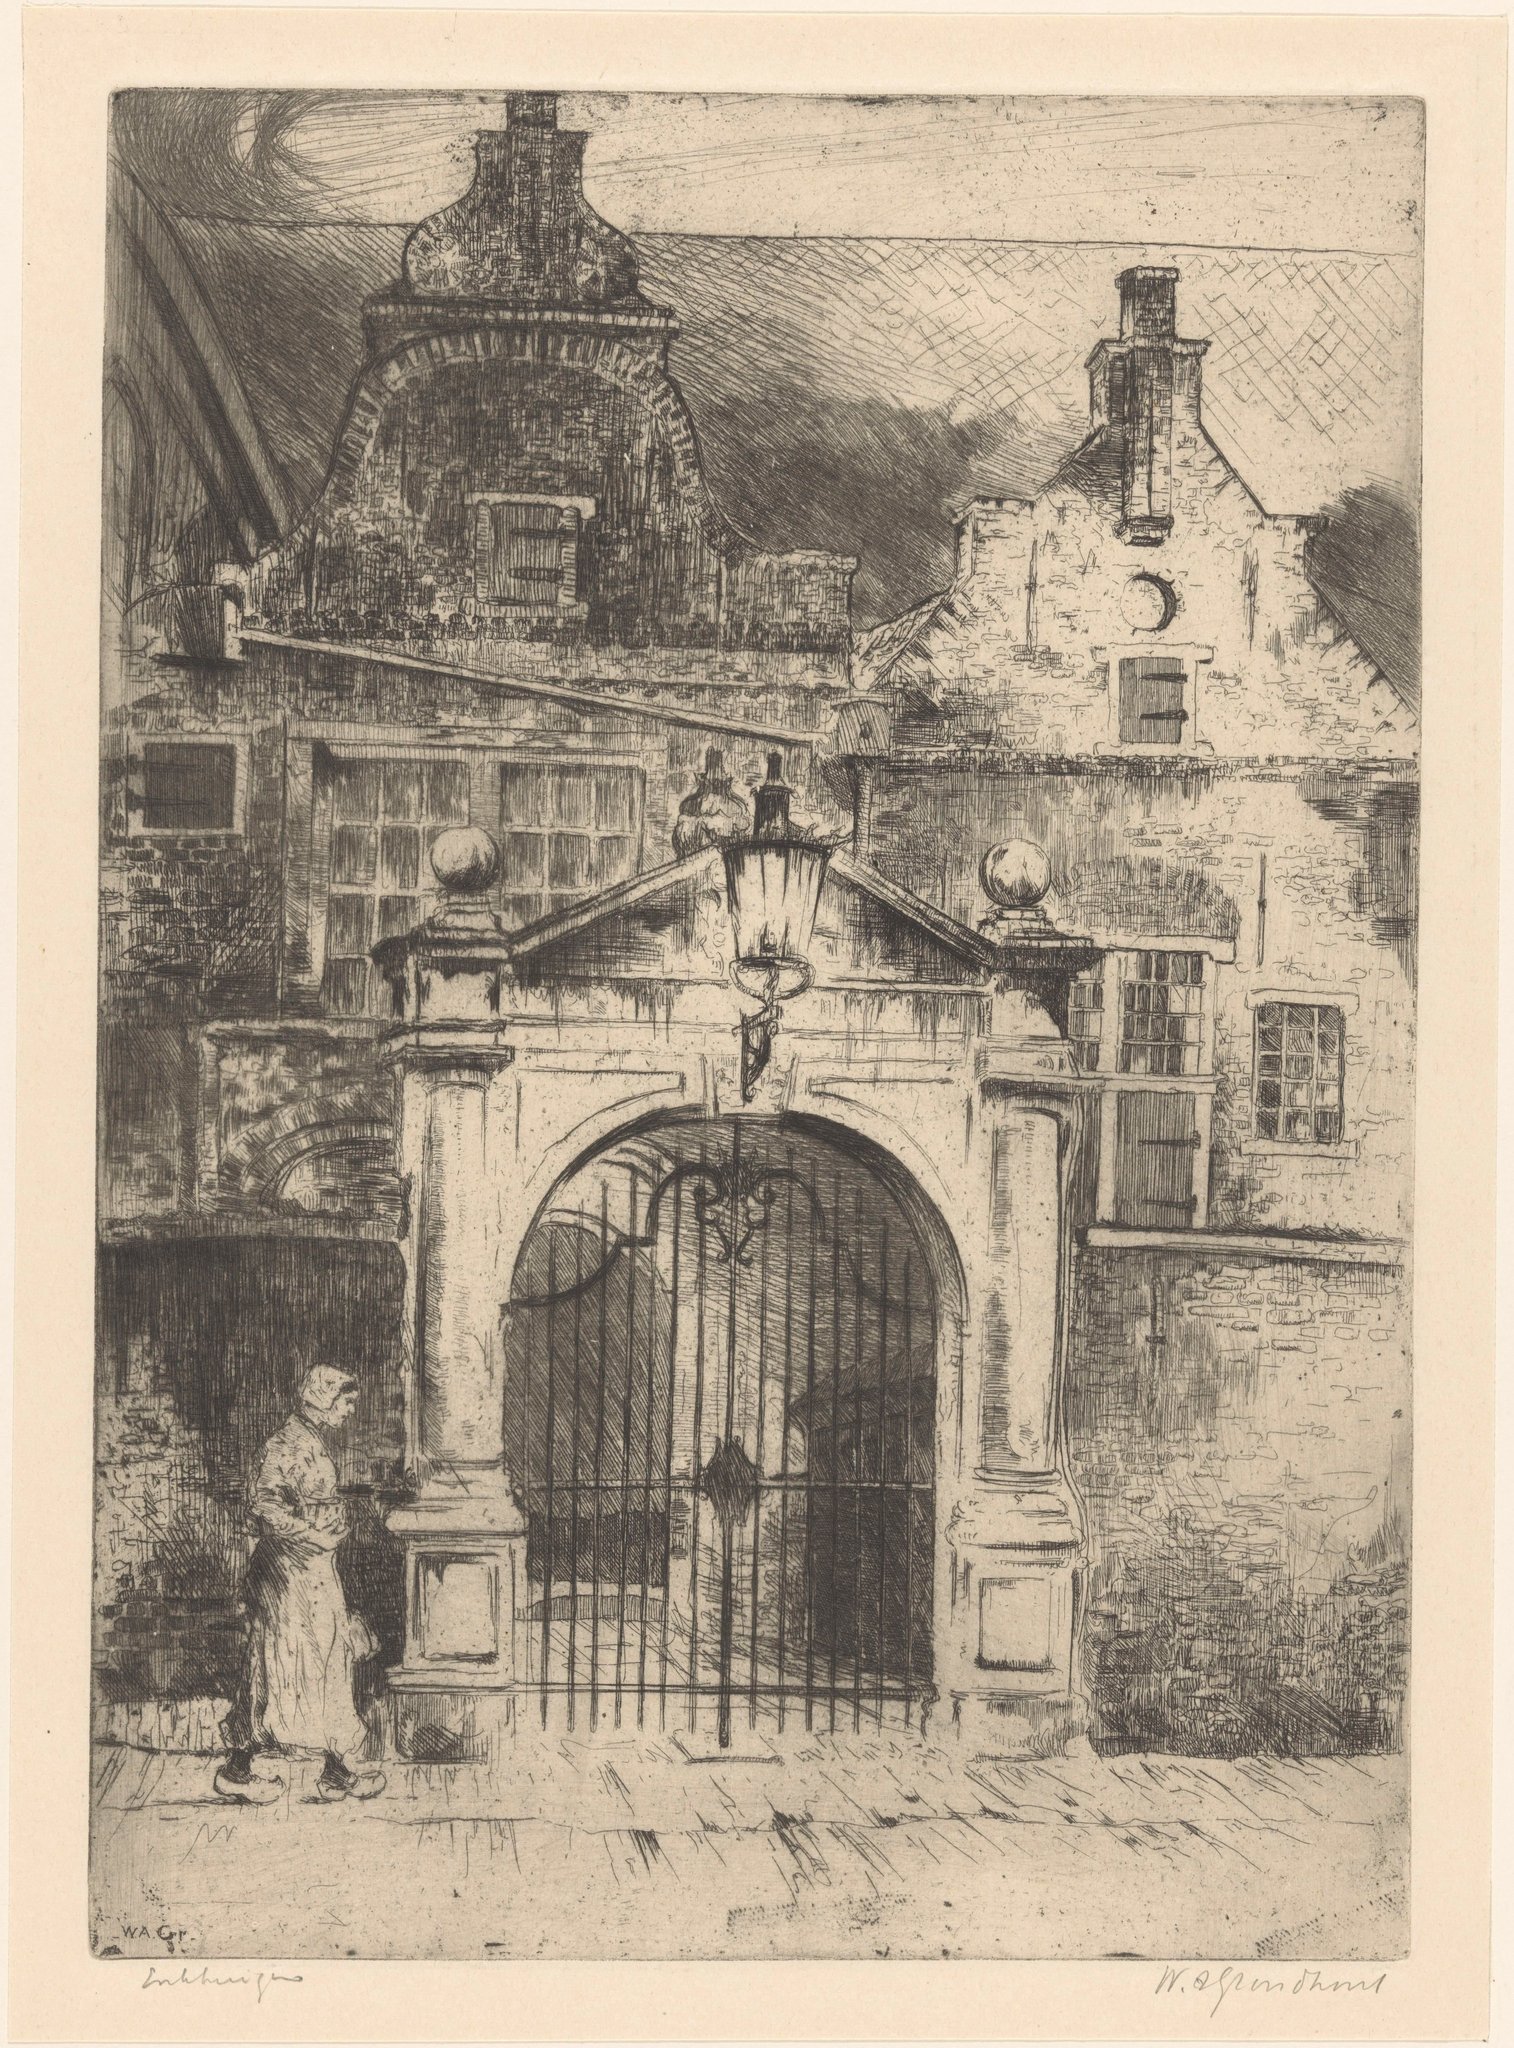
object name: print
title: Enkhuizen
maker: willem adrianus grondhout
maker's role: draughtsman, painter, print maker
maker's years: 1878-1934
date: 1888-1931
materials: paper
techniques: etching, intaglio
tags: gate, entrance, walking - aa - female human figure, enkhuizen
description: Een toegangspoort van de Zuider- of Sint-Pancraskerk in Enkhuizen. Op de voorgrond een vrouw die op straat wandelt.